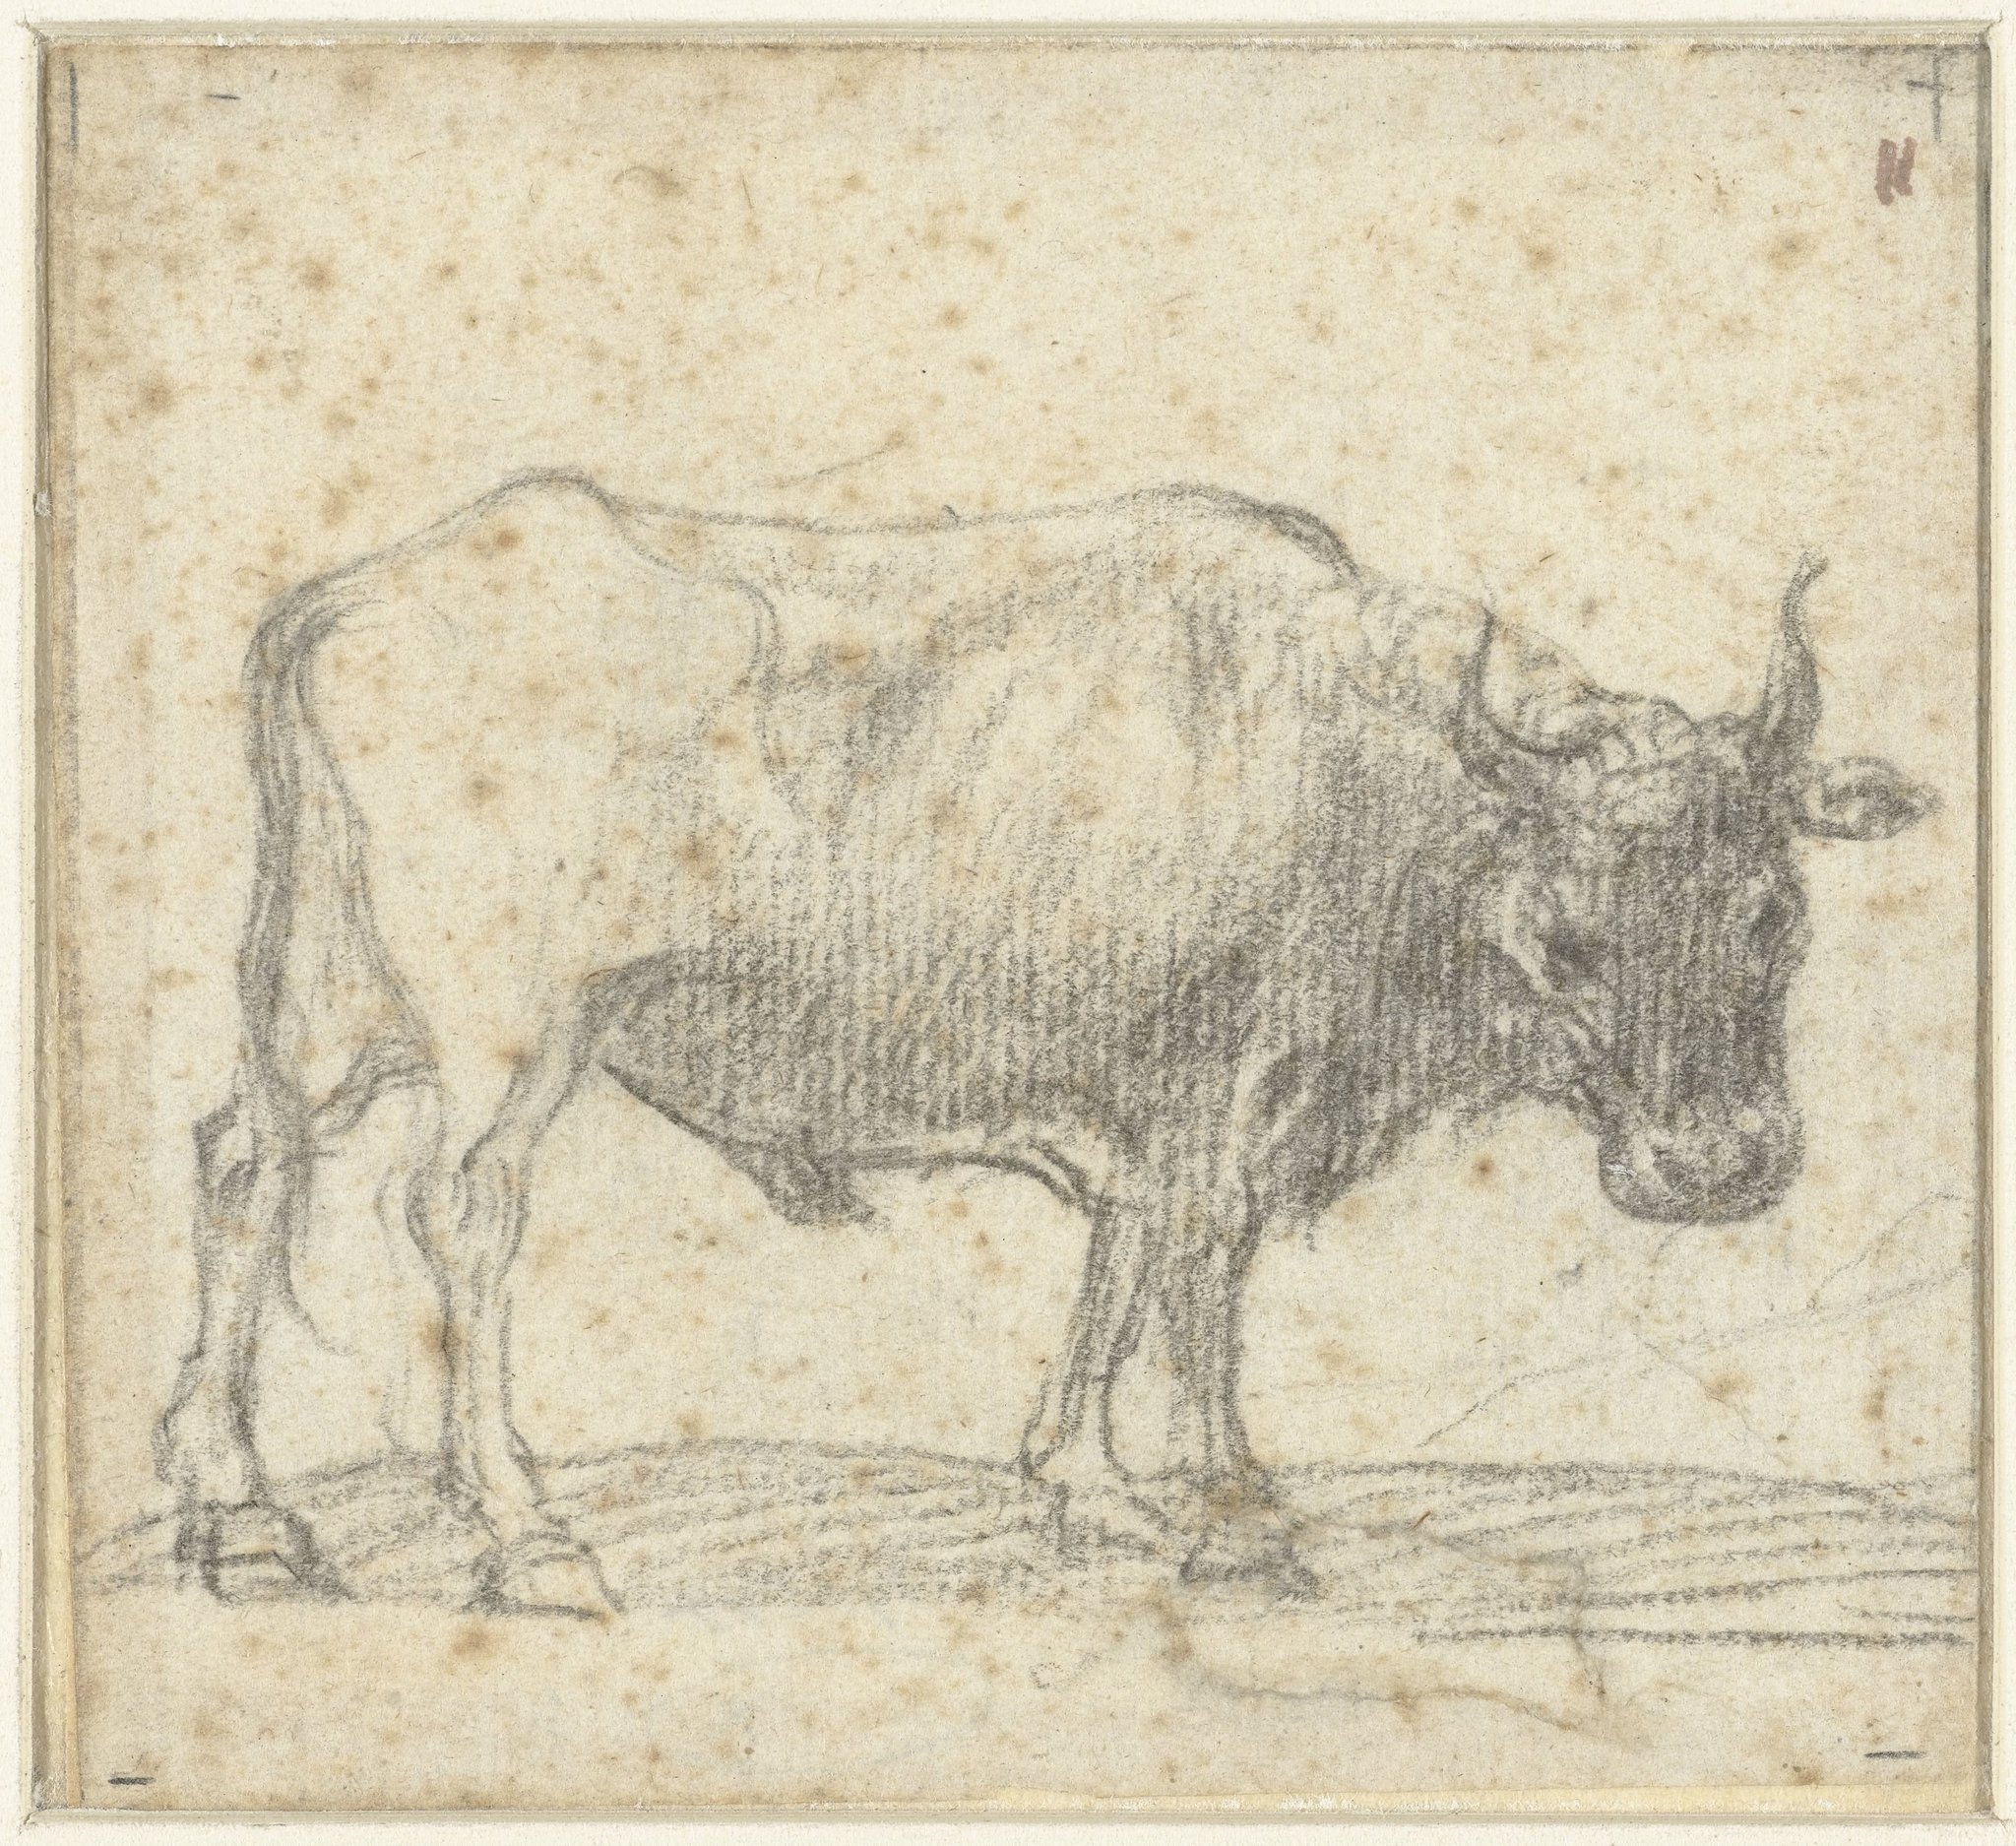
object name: drawing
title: Studies van vee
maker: claude lorrain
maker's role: draughtsman, print maker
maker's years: 1604-1682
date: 1635-1645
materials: chalk, paper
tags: ox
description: Bladen van serie zijn afkomstig uit een schetsboek.